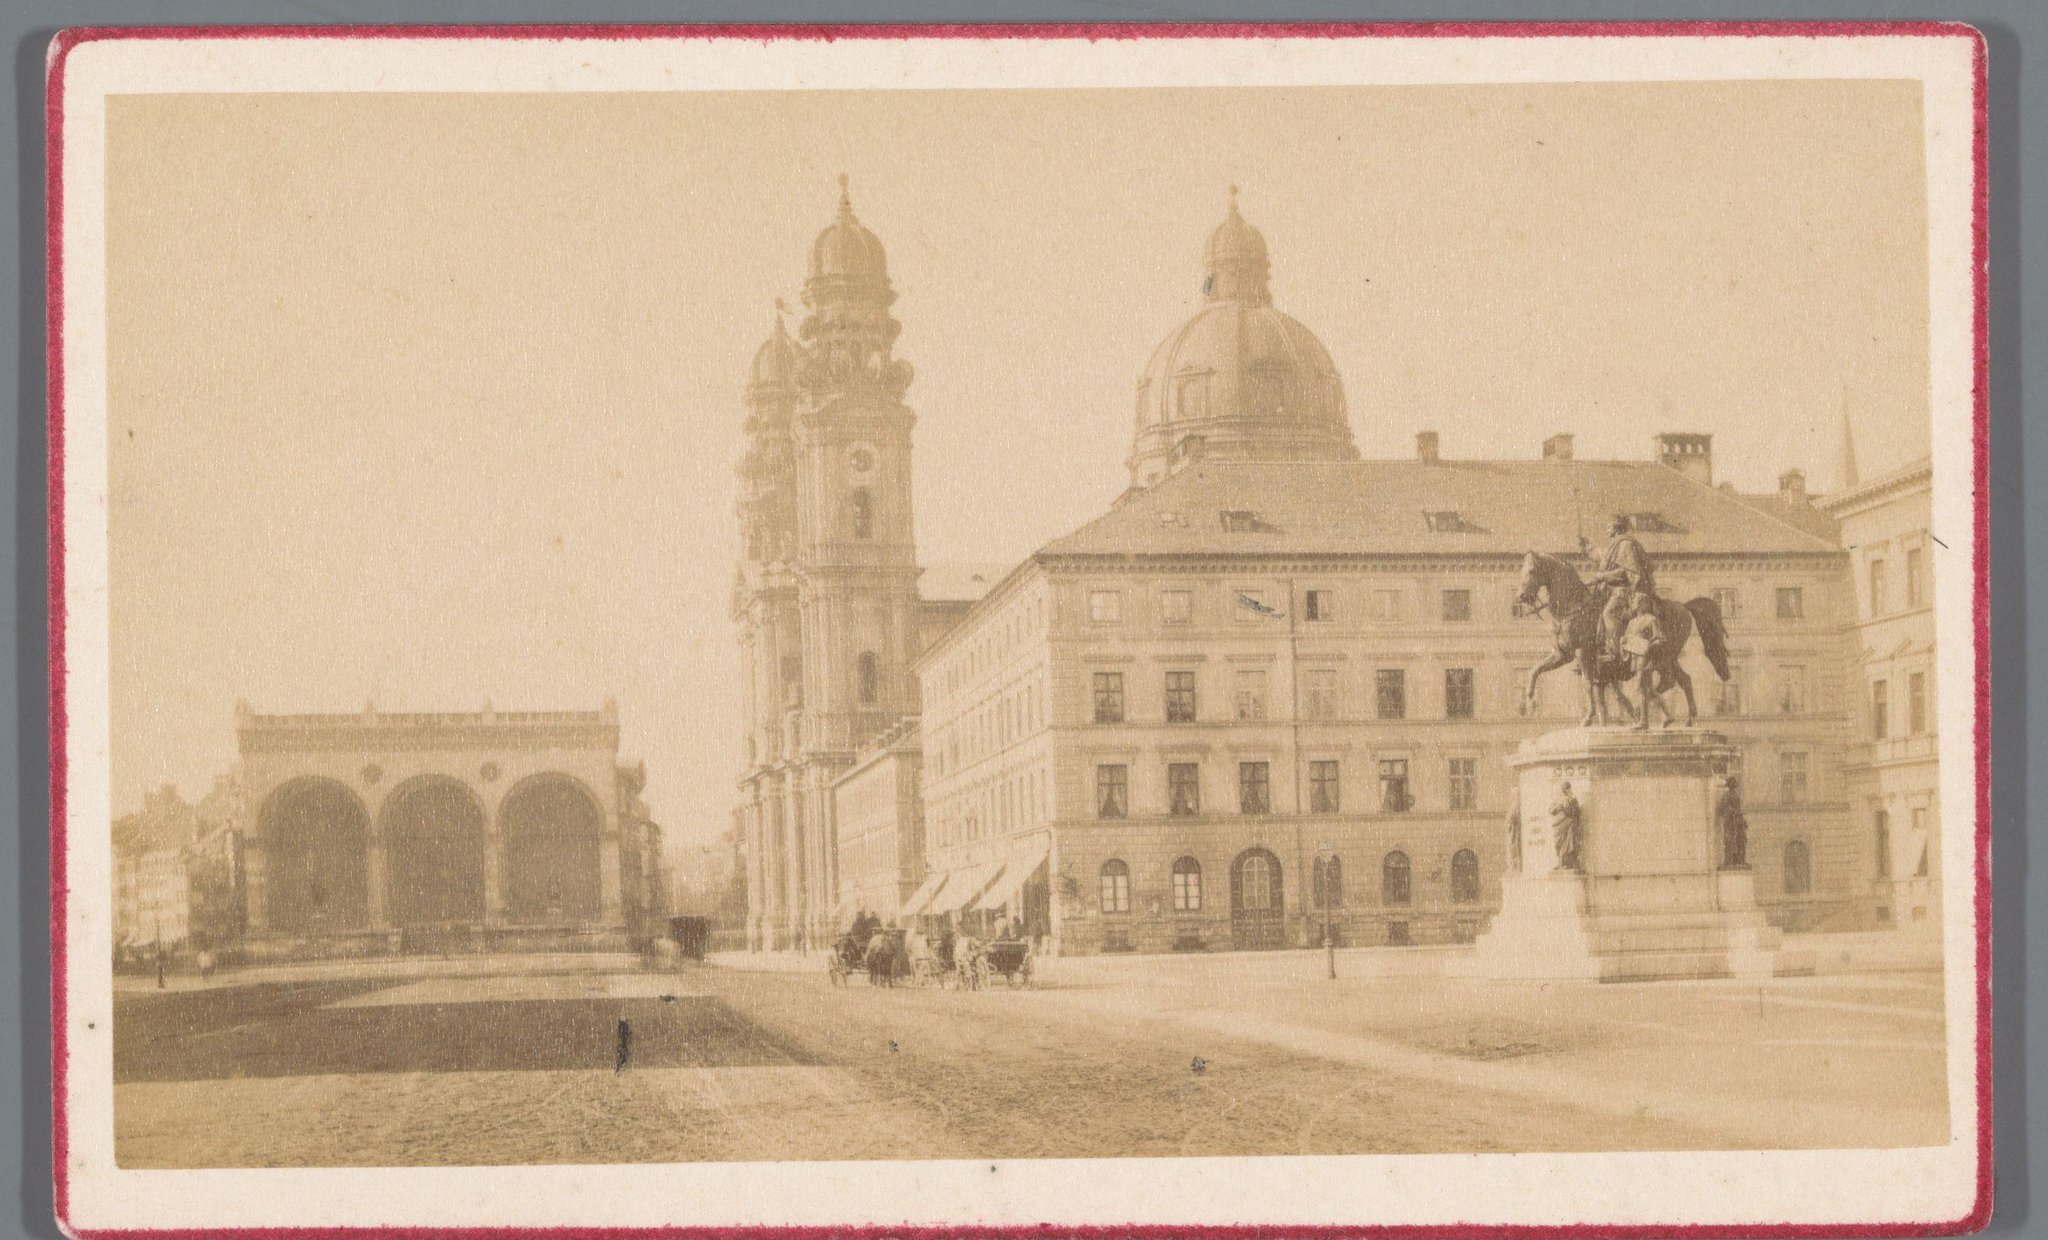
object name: carte de visite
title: Odeonsplatz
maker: Anonymous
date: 1855-1885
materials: cardboard, paper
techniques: albumen print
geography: munich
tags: lodewijk i (koning van beieren), square, place, circus, etc., church (exterior), equestrian statue, loggia, verandah, porch